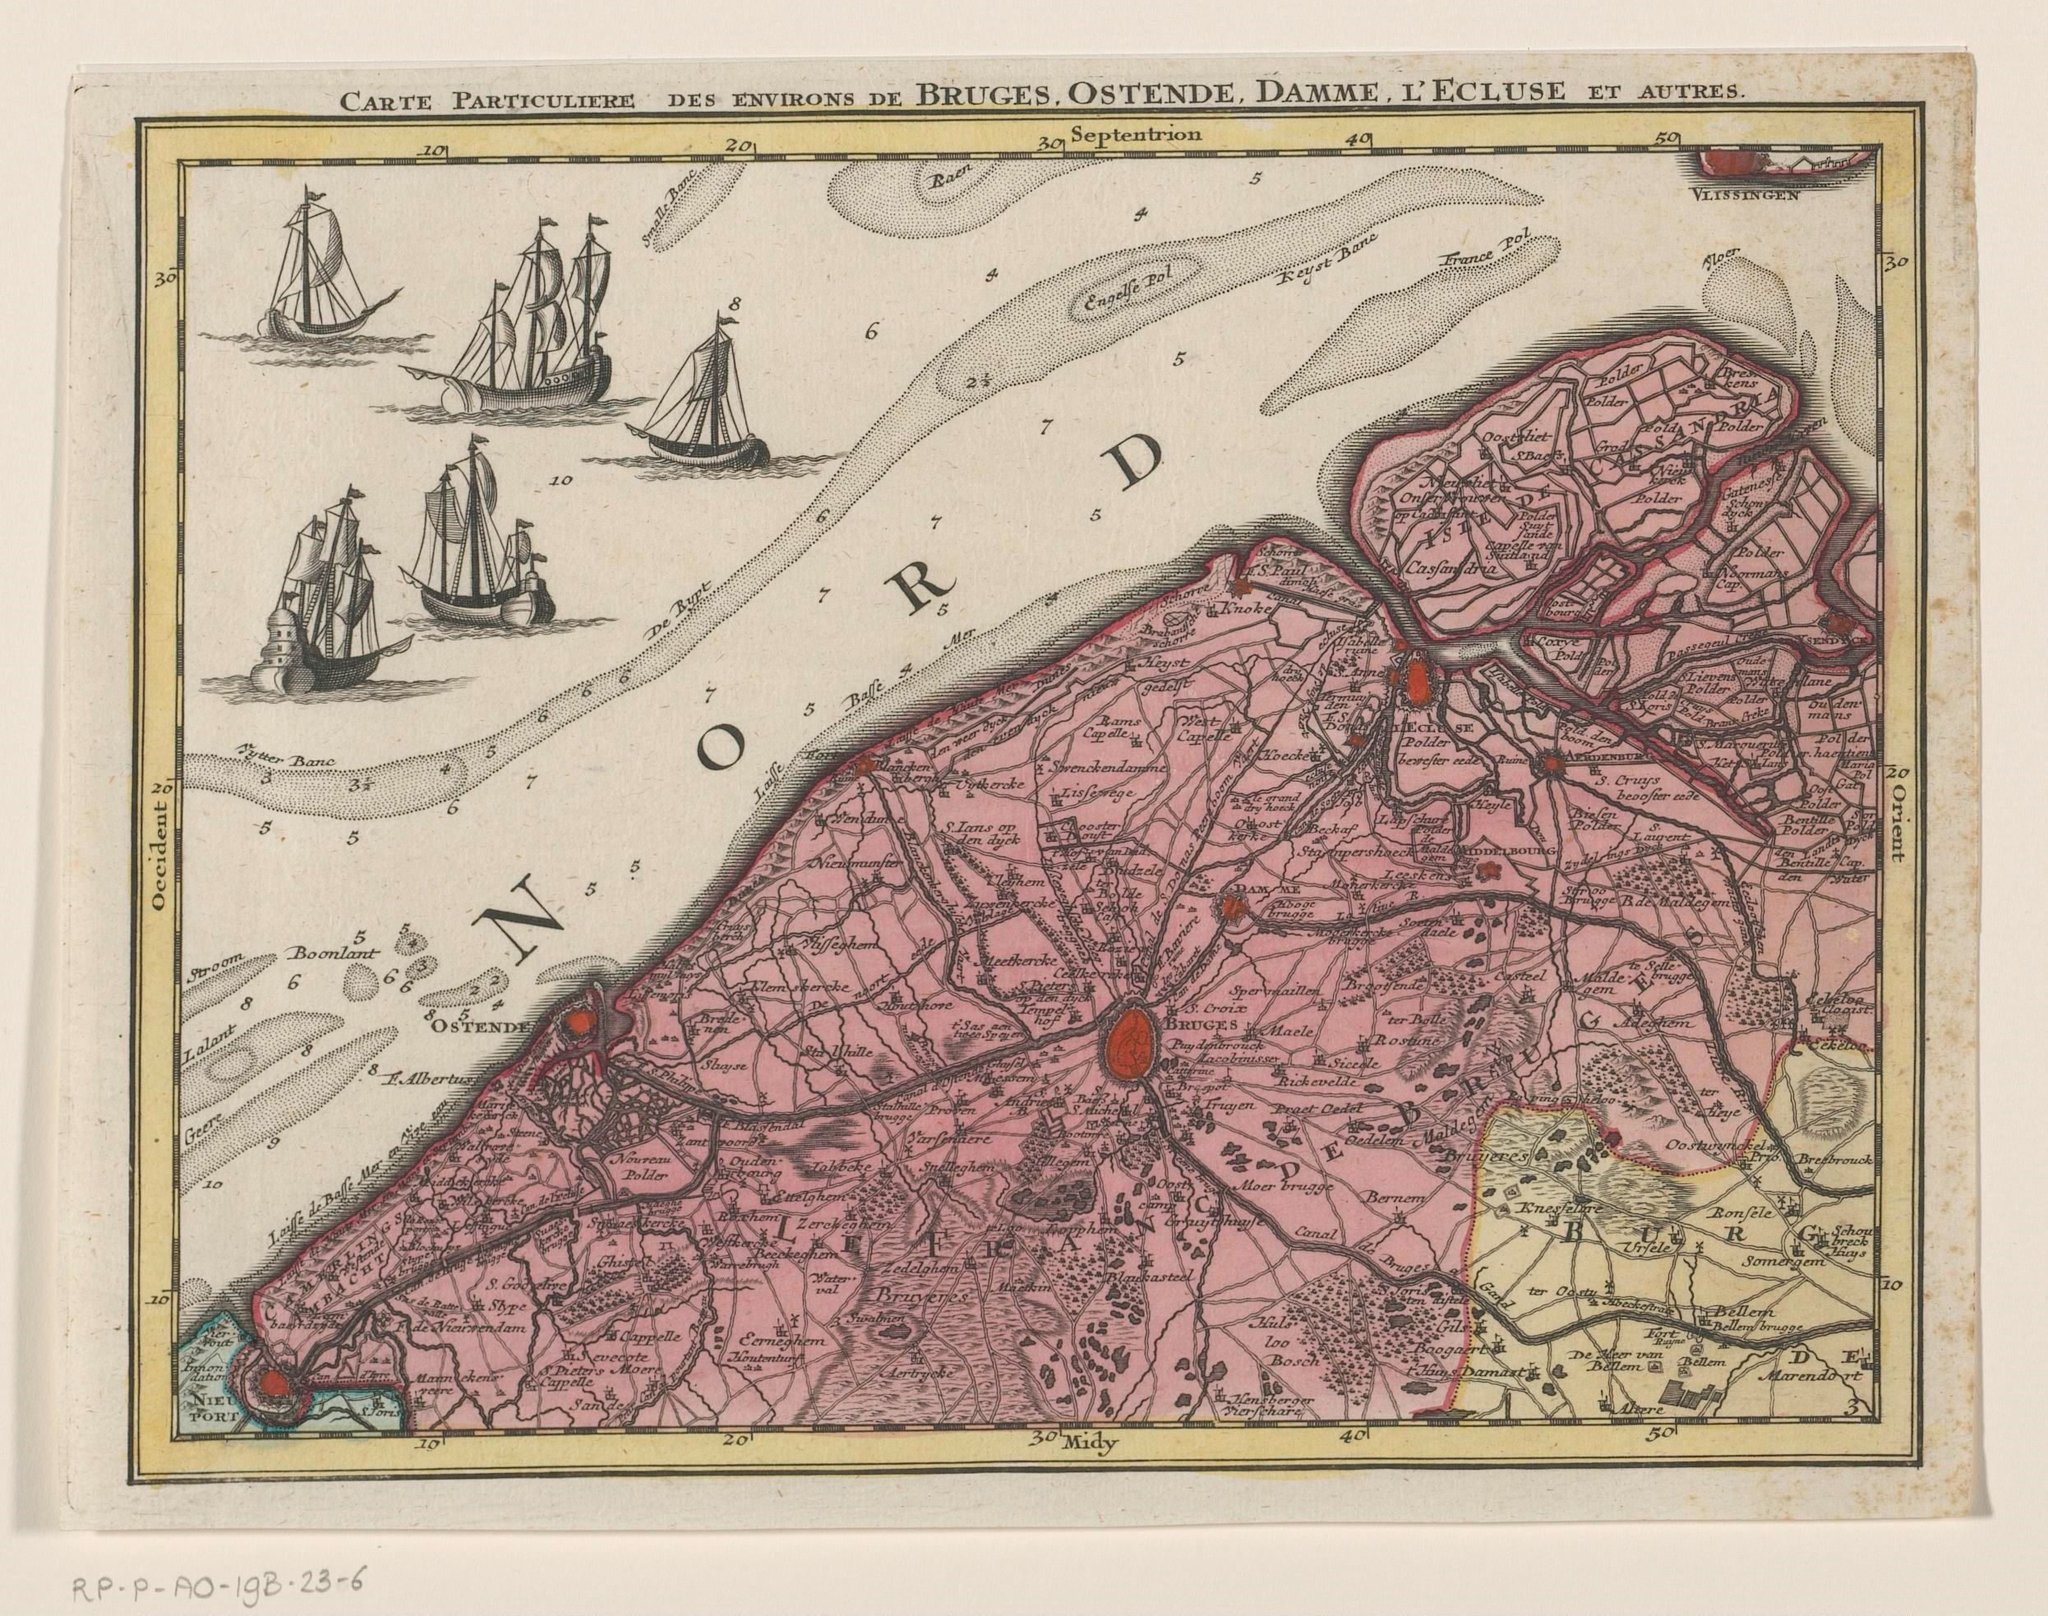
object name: map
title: Carte Particuliere des environs de Bruges, Ostende, Damme, l'Ecluse et autres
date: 1737-1757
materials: paper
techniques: engraving, etching, hand coloring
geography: augsburg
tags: maps of separate countries or regions, southern netherlands, belgium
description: Deze kaart is onderdeel van een wandkaart van de Oostenrijkse Nederlanden, bestaande uit vier rijen van zes delen. De delen van de kaart zijn rechtsonder genummerd, beginnend bij het deel linksboven (1) tot het deel rechtsonder (24).